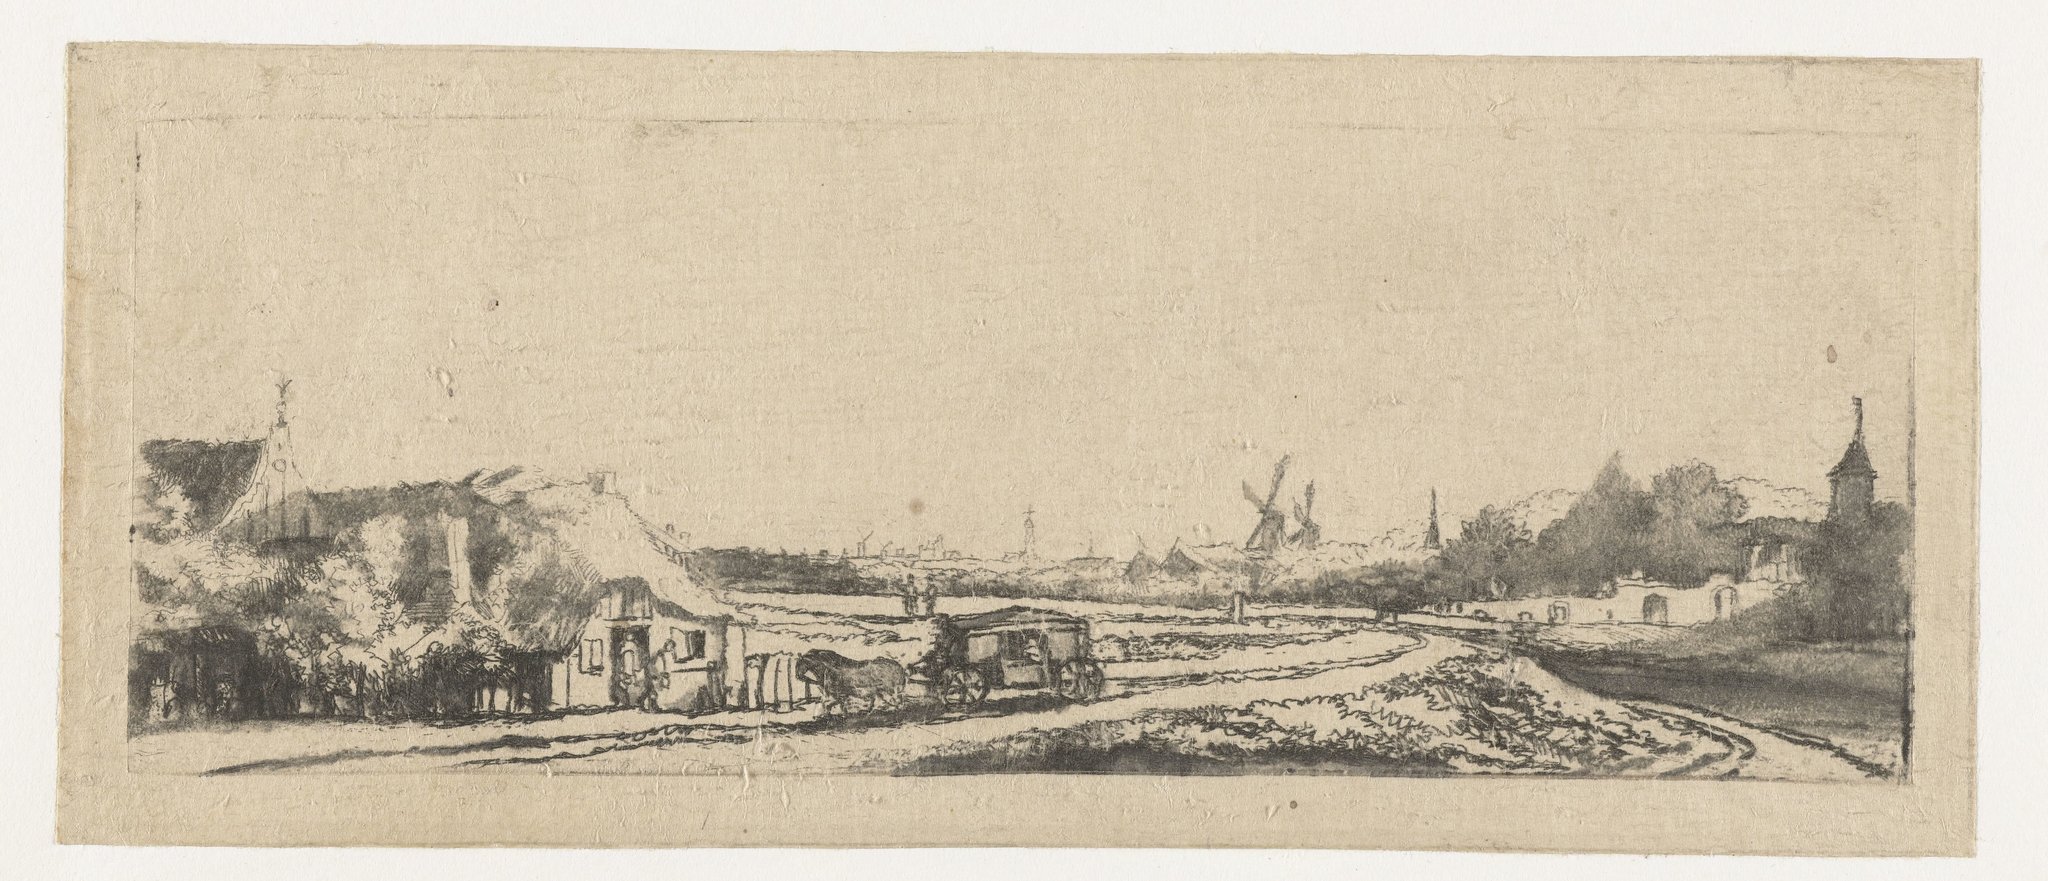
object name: print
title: Landschap met een koets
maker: philips koninck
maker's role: draughtsman, painter, print maker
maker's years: 1619-1688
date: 1629-1688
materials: paper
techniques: etching, intaglio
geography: netherlands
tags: four-wheeled, animal-drawn vehicle, e.g.: cab, carriage, coach, public road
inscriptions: collector's mark: Lugt 240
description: Een landweg met een koets nabij een huis. In de verte twee molens en de contouren van een stad.